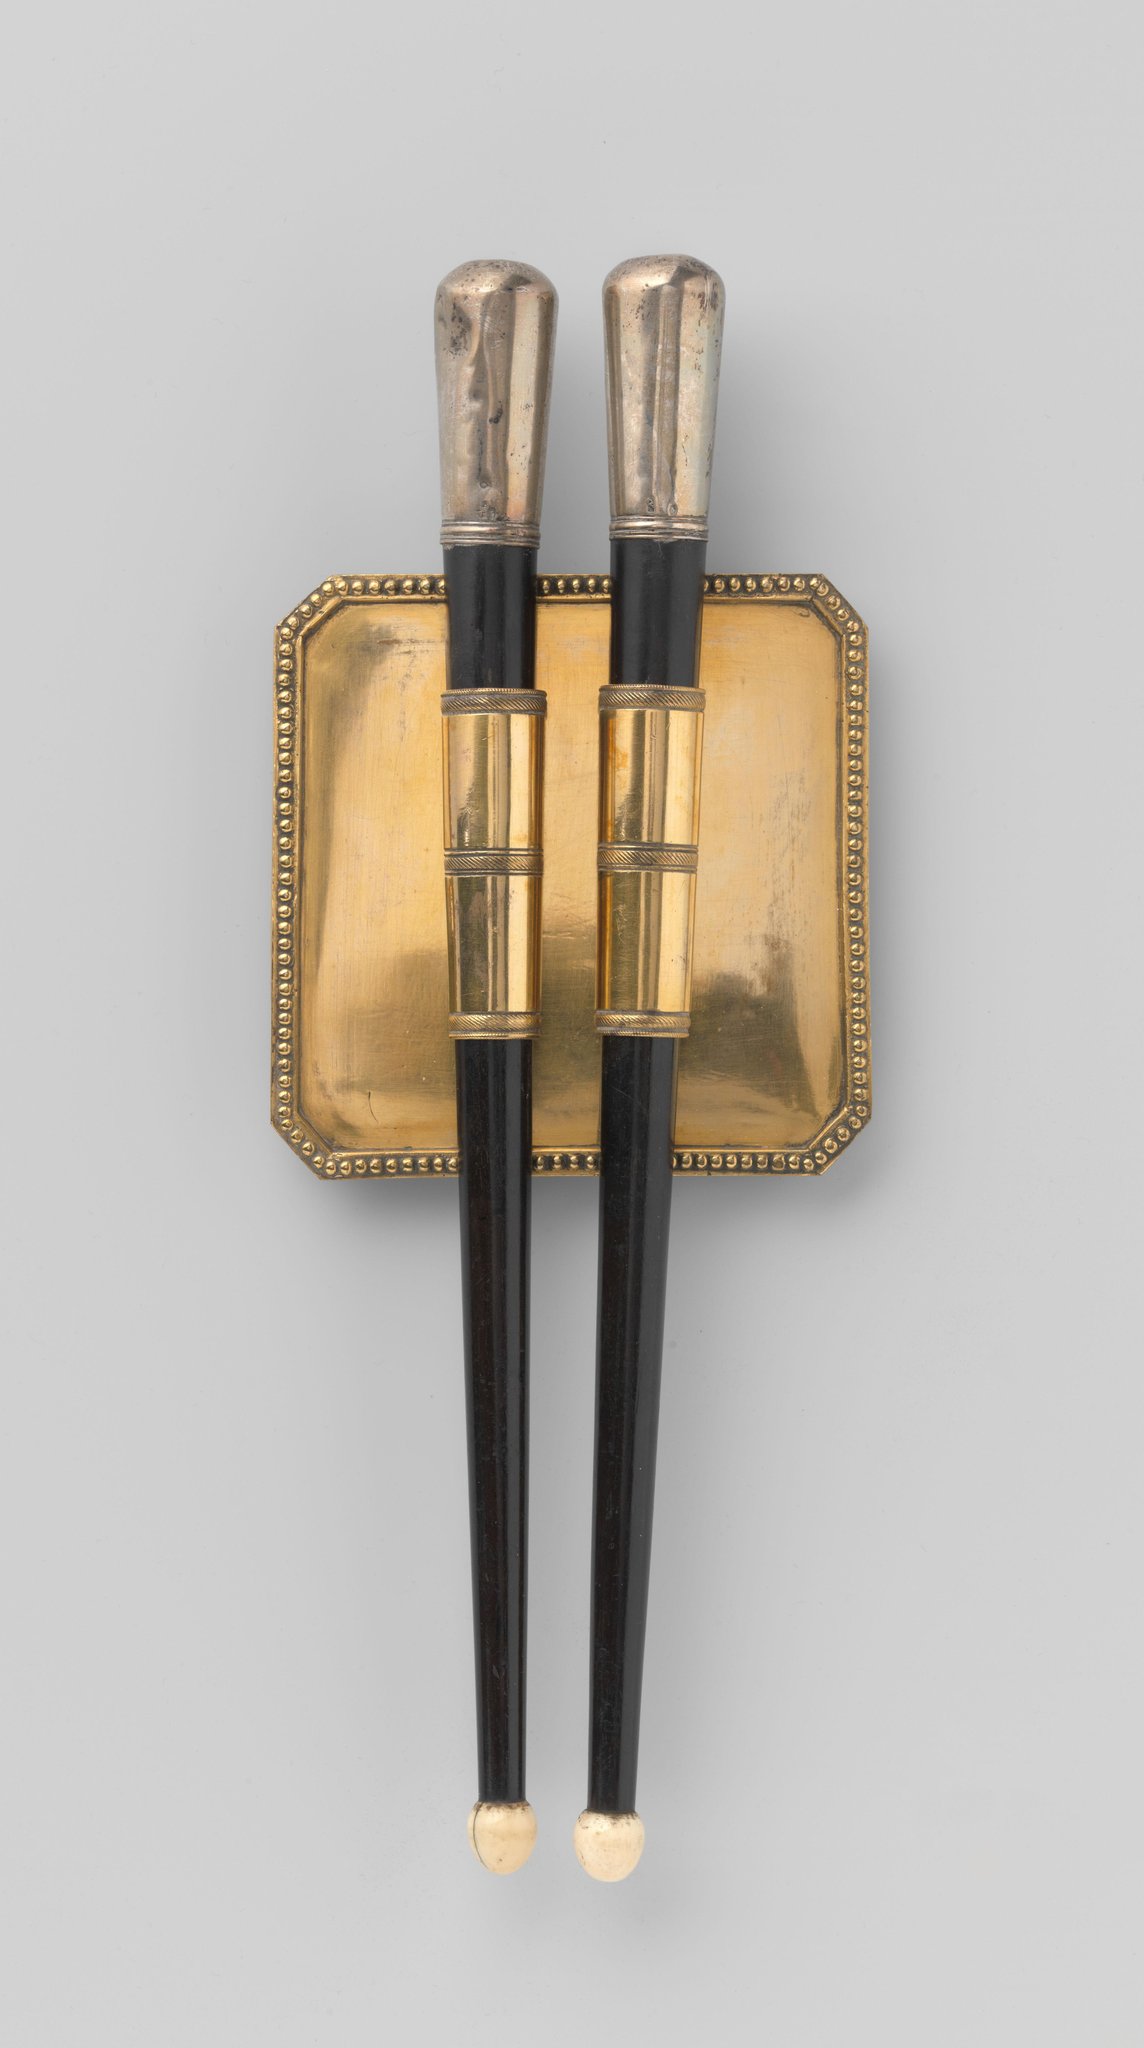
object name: beater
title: Drumsticks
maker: Anonymous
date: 1817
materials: wood, ivory, silver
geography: netherlands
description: Een ebbenhouten tromstok met ivoren knop.